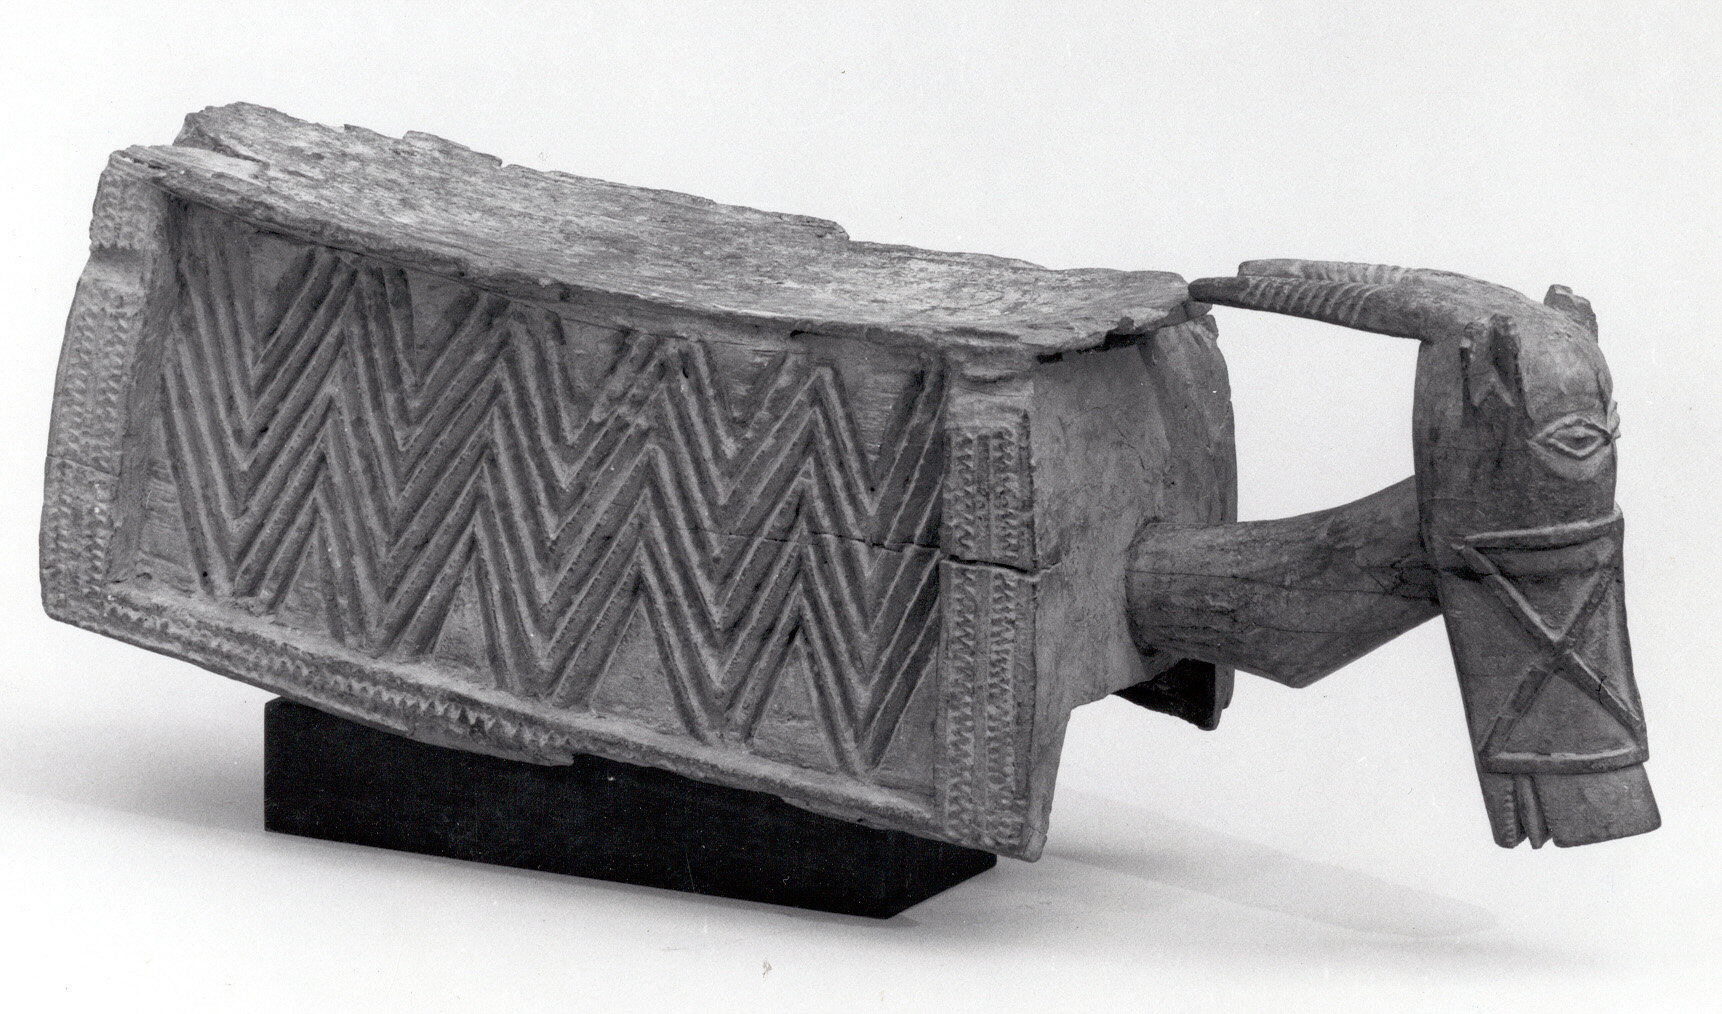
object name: stool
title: Stool: Zoomorphic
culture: dogon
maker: dogon blacksmith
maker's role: artist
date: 1401-1900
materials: wood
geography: mali